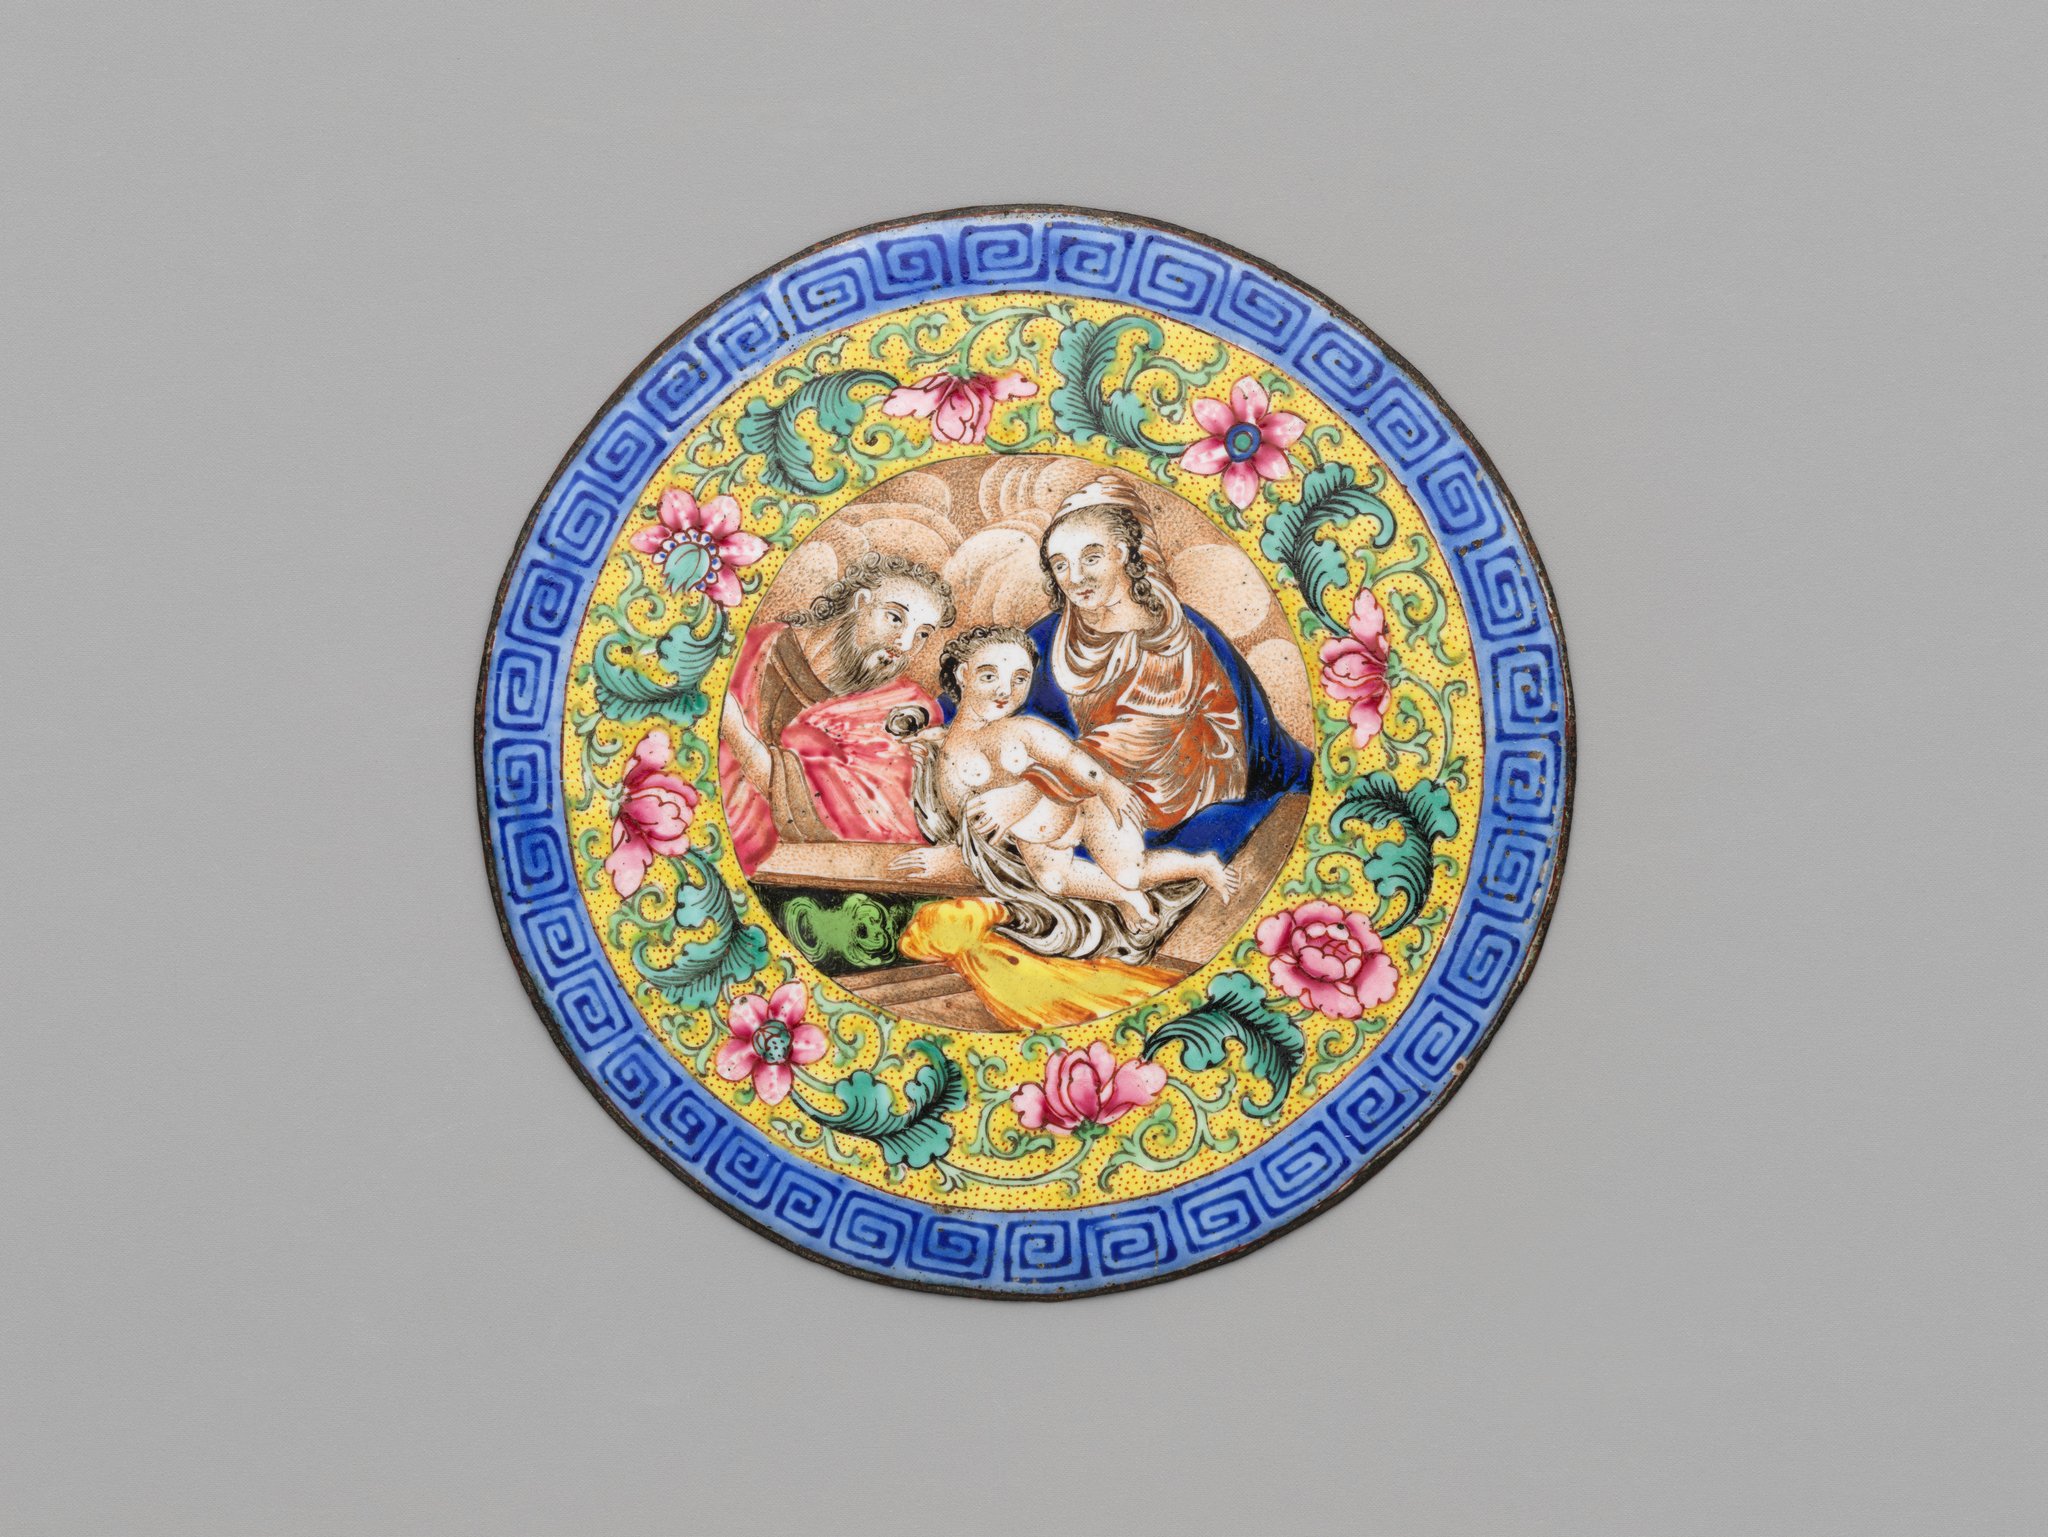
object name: plaque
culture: chinese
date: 1736-1795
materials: enamel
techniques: painting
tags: holy family